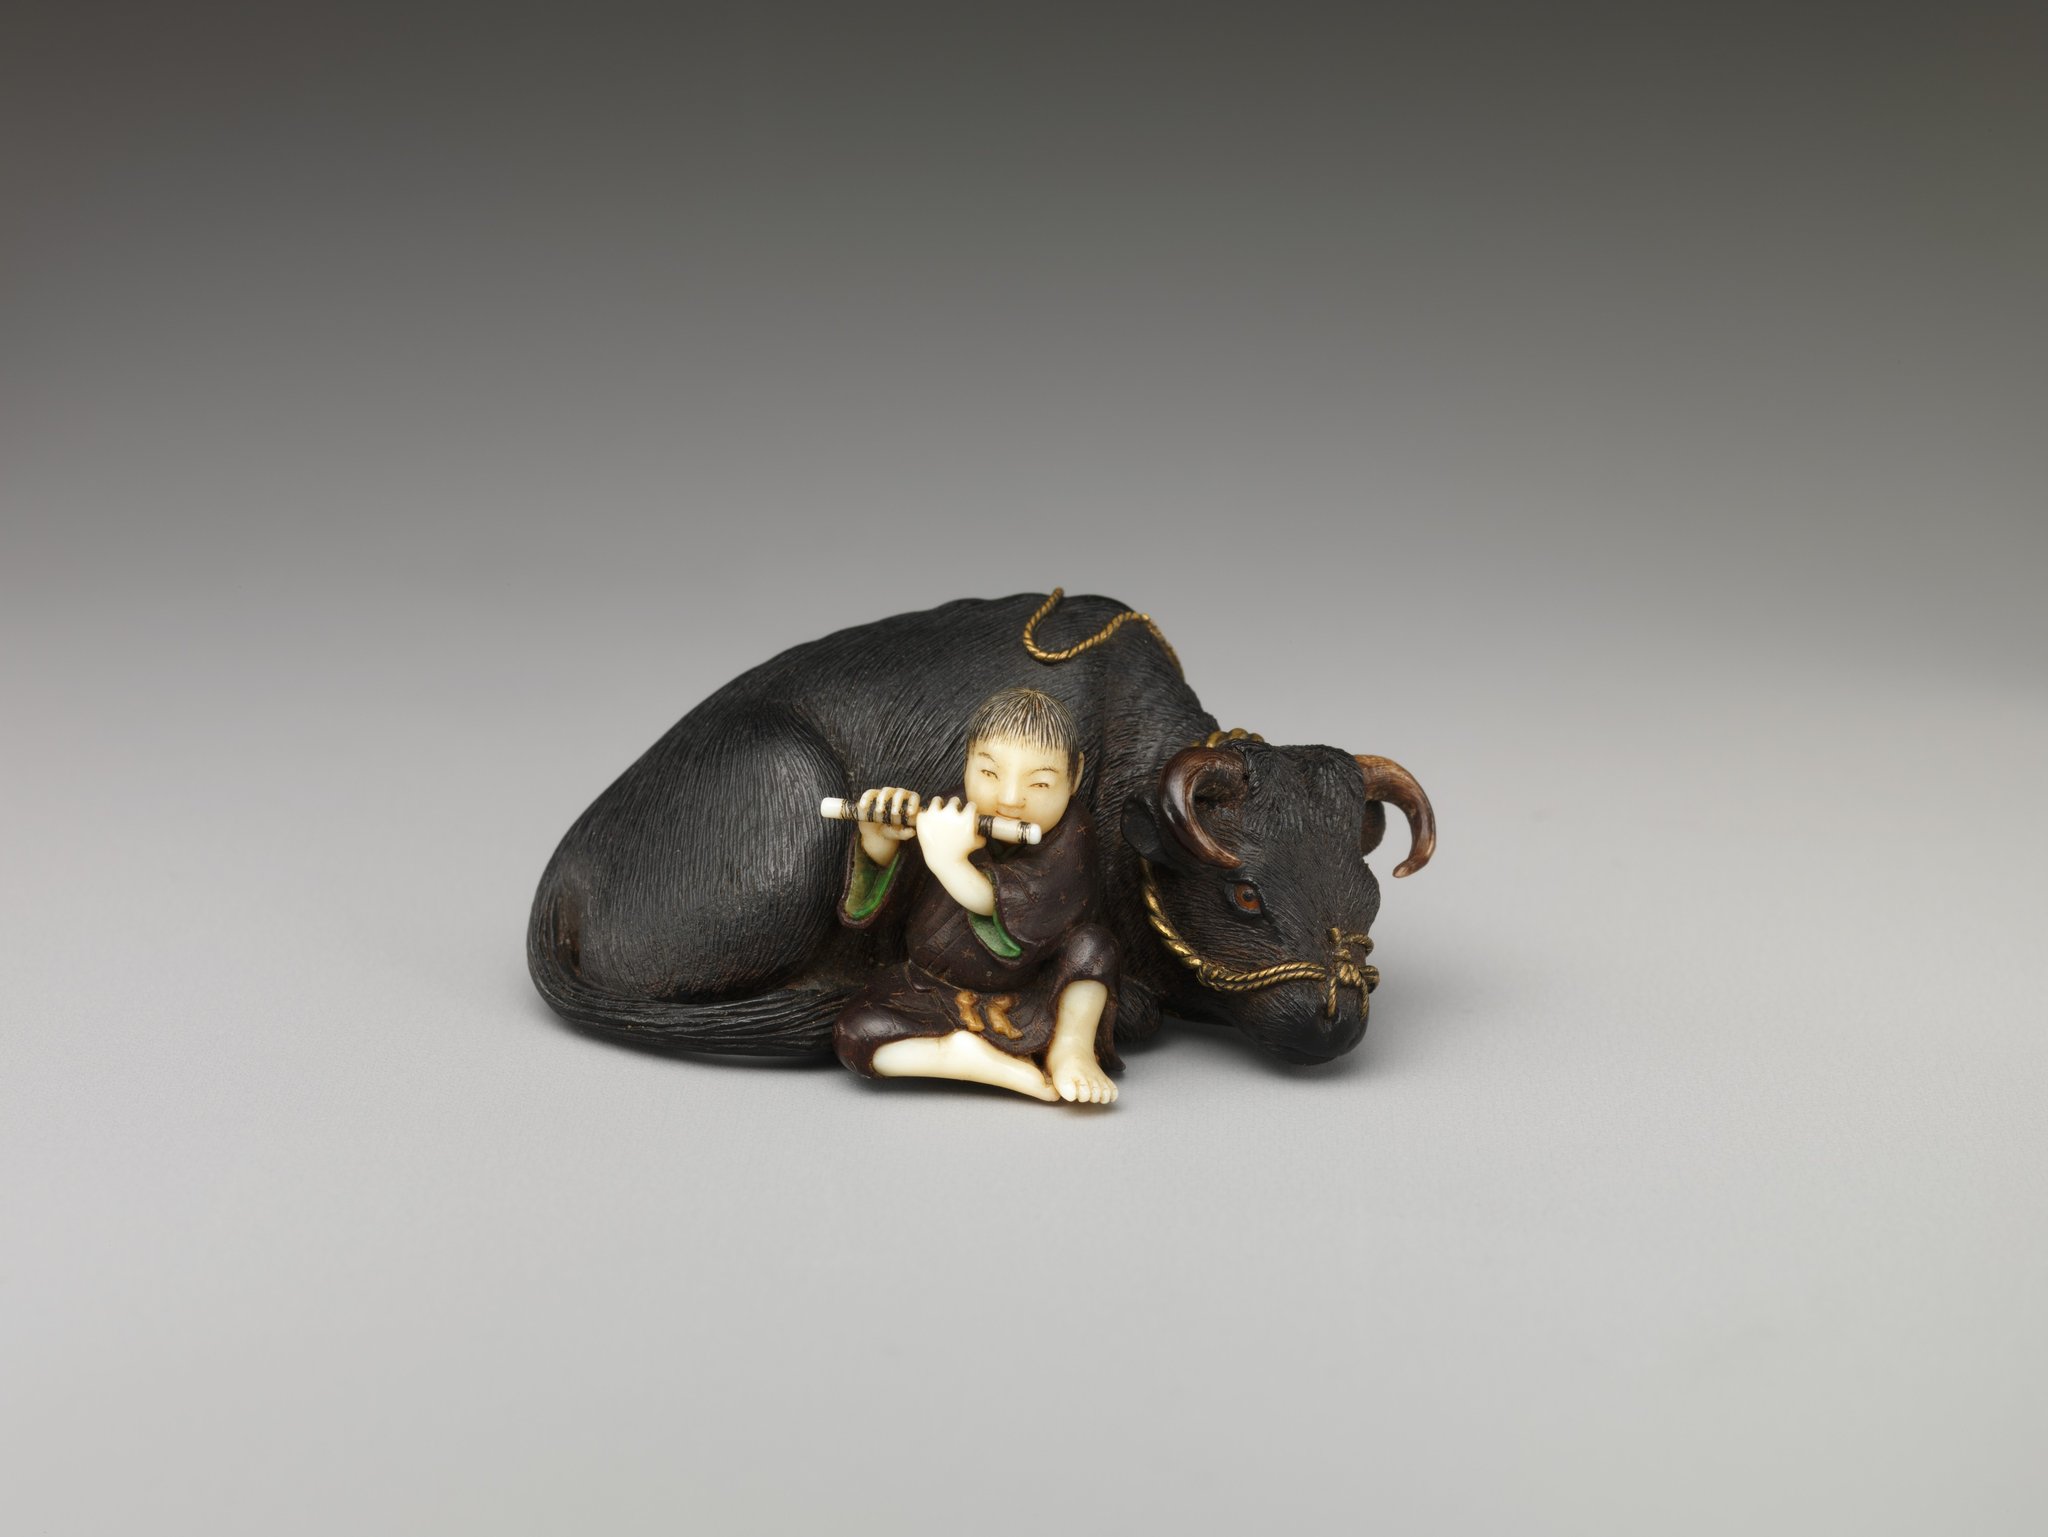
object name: netsuke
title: Netsuke of Ox with Bokudo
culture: japanese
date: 1801-1900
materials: ivory, wood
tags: boys,flutes,ox